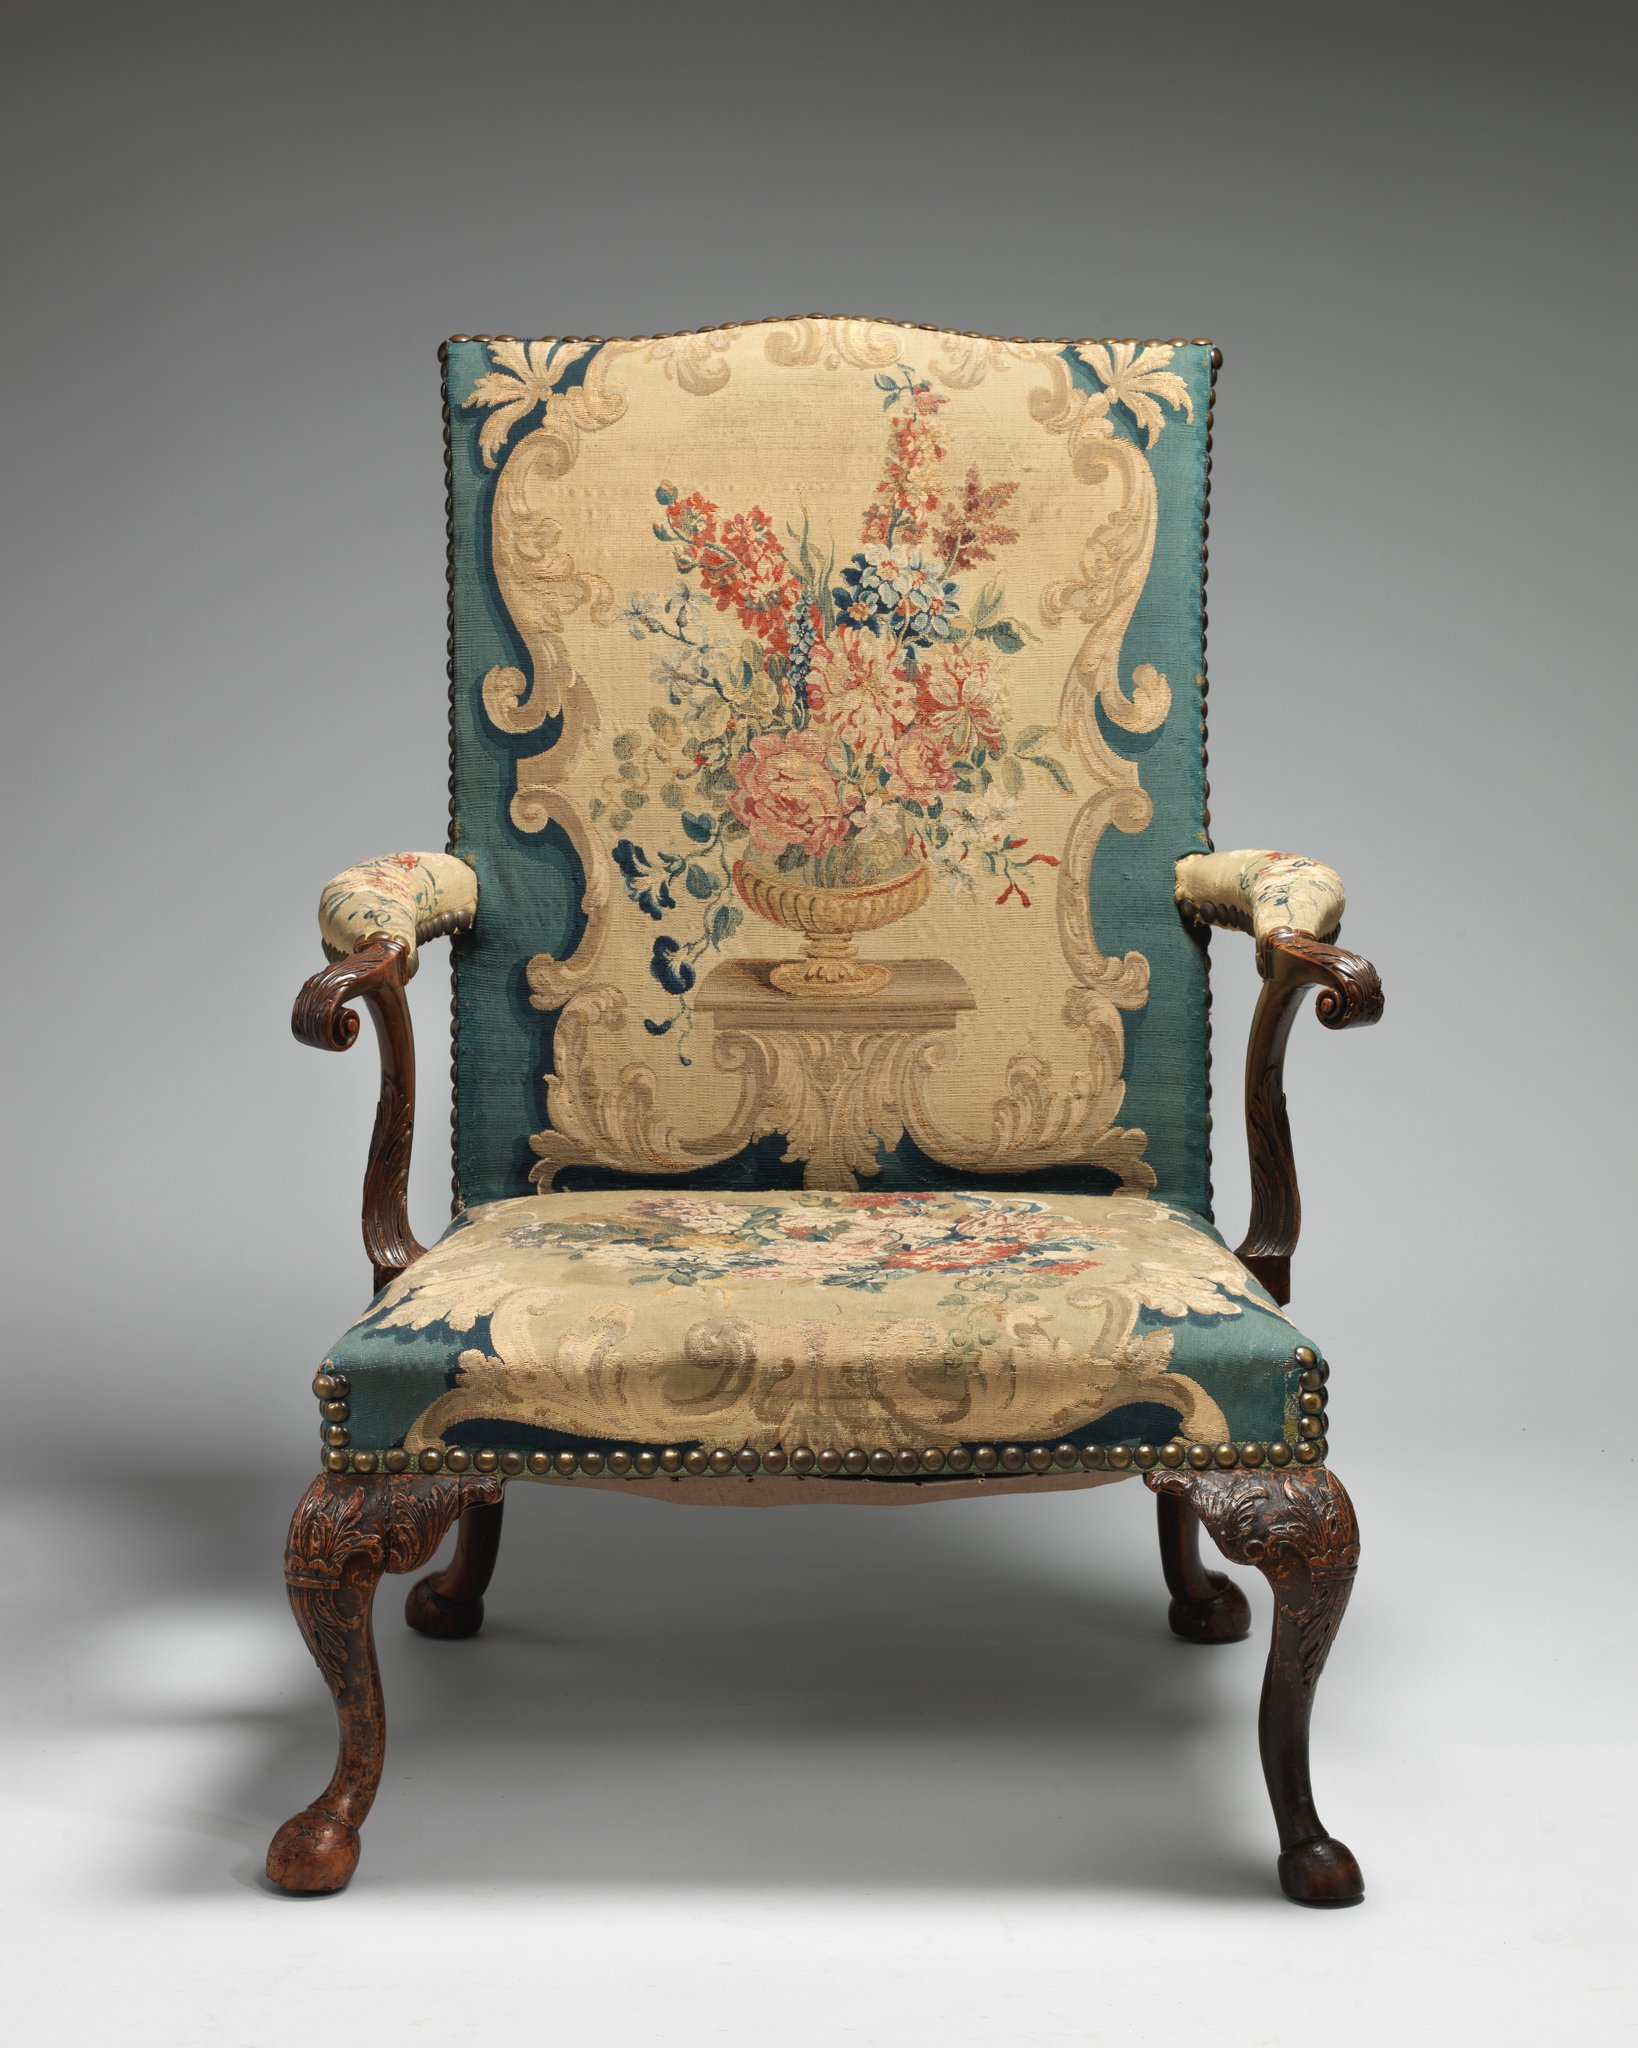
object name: armchair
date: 1740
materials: wood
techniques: tapestry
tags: flowers